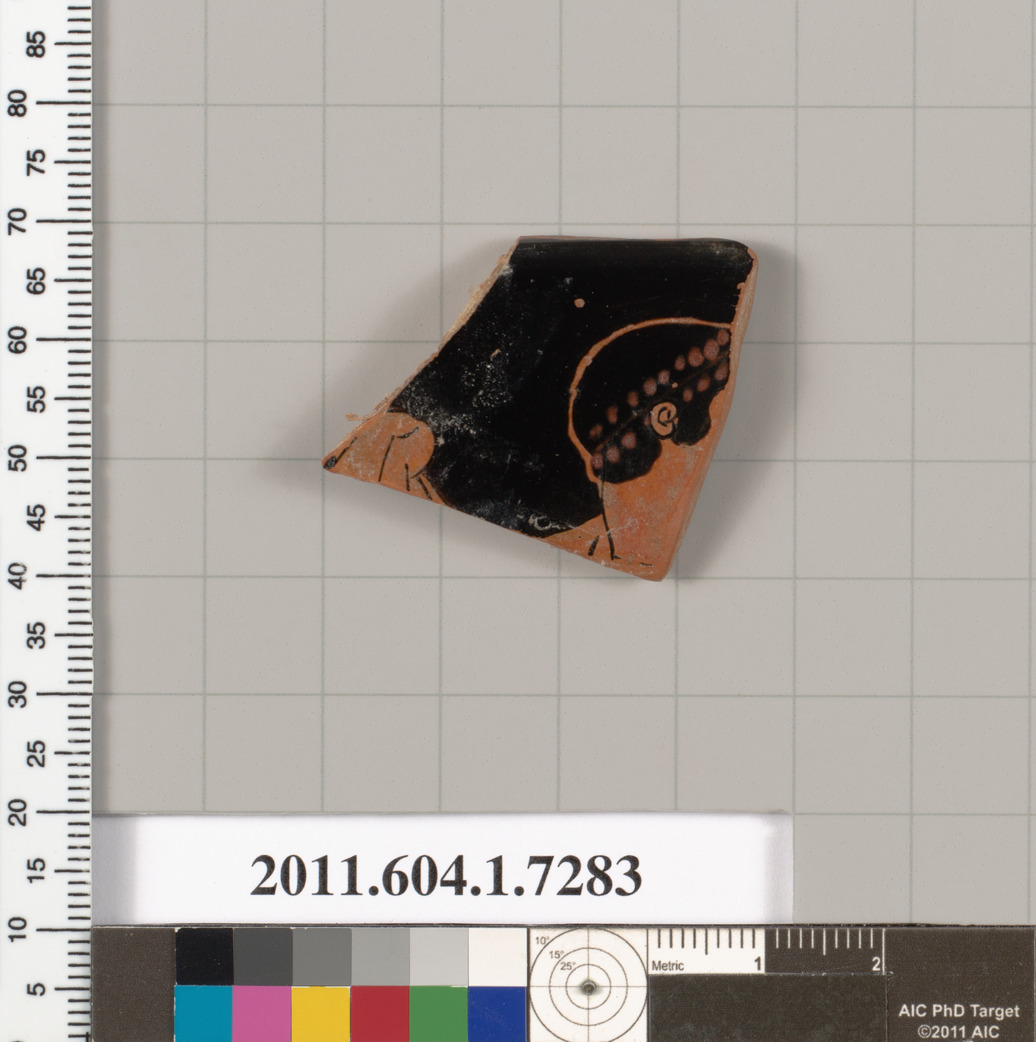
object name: kylix fragment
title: Terracotta rim fragment of a kylix (drinking cup)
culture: greek, attic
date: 500-480 BCE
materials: terracotta